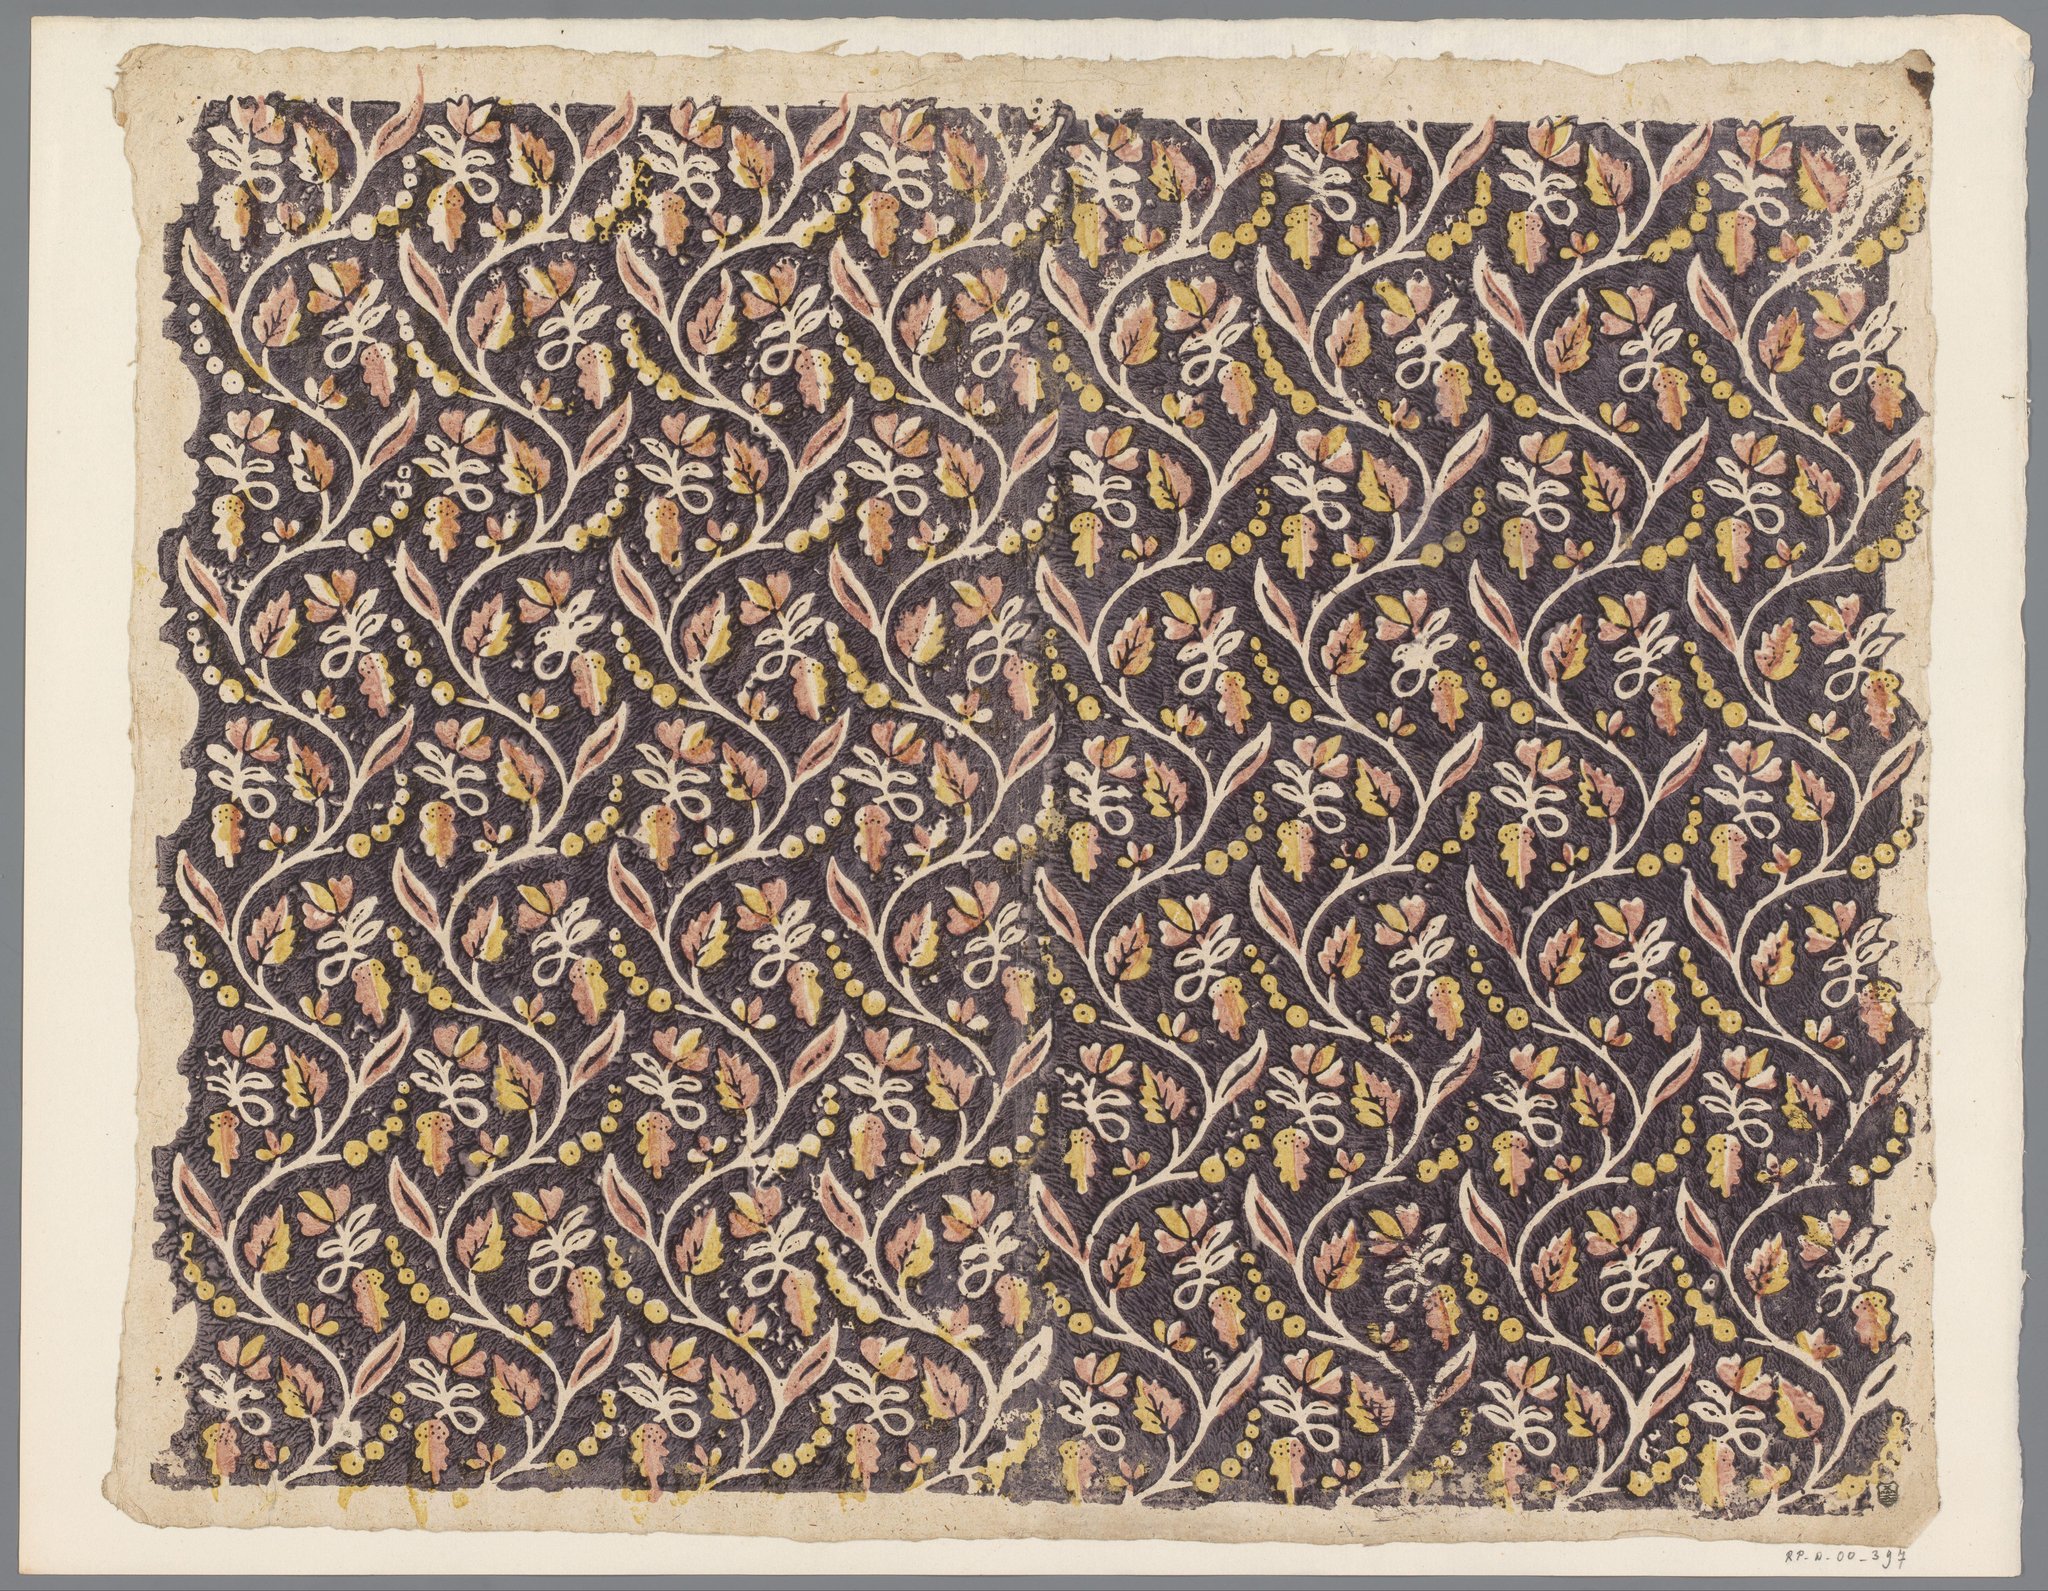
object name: printed paper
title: Blad met uitgespaarde slingerende ranken met bloemen en vruchten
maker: Anonymous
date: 1700-1850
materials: paper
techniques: printing block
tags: ornament derived from plant forms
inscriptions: collector's mark: Lugt 2760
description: Blad met uitgespaarde verticaal naast elkaar slingerende ranken met bloemen en vruchten.